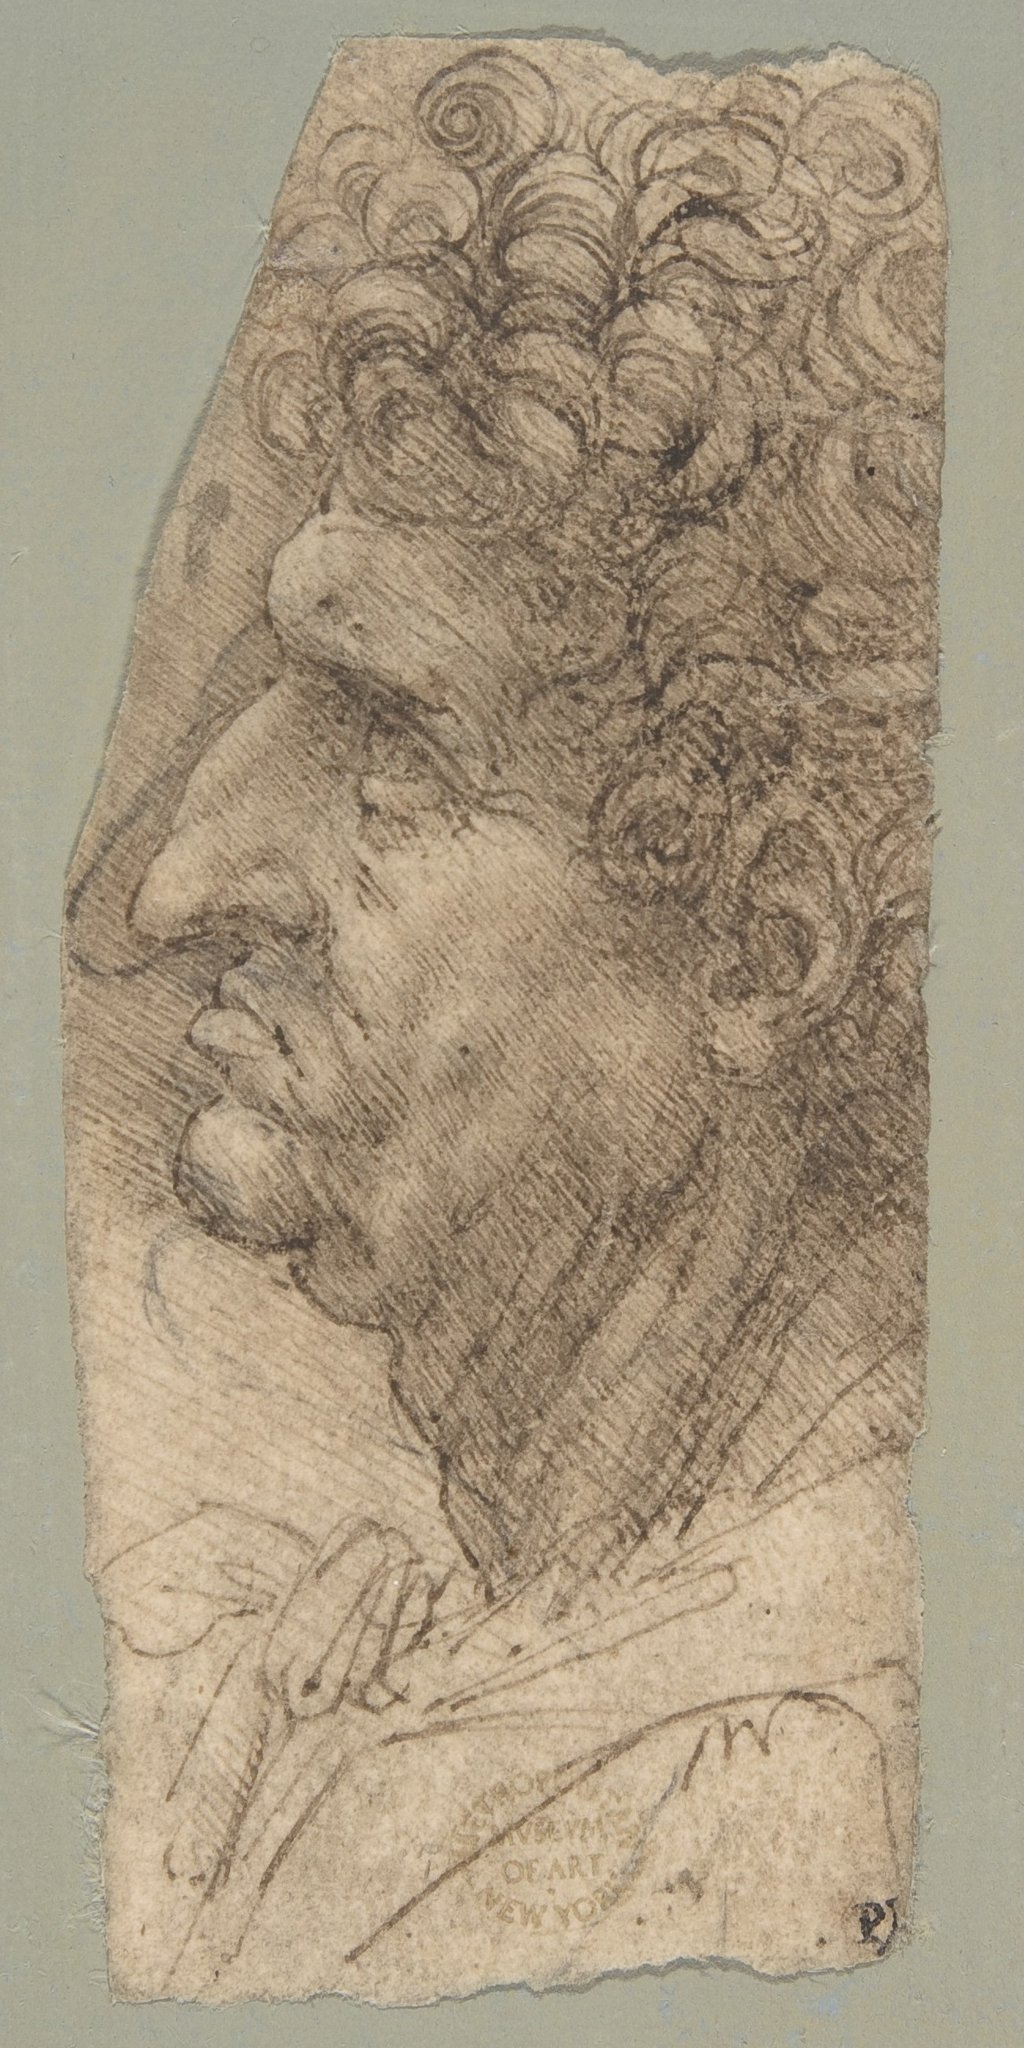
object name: drawing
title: Head of a Man in Profile Facing to the Left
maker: leonardo da vinci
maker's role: artist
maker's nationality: italian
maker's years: 1452-1519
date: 1490-1494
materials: chalk, ink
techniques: pen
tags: heads,men,profiles